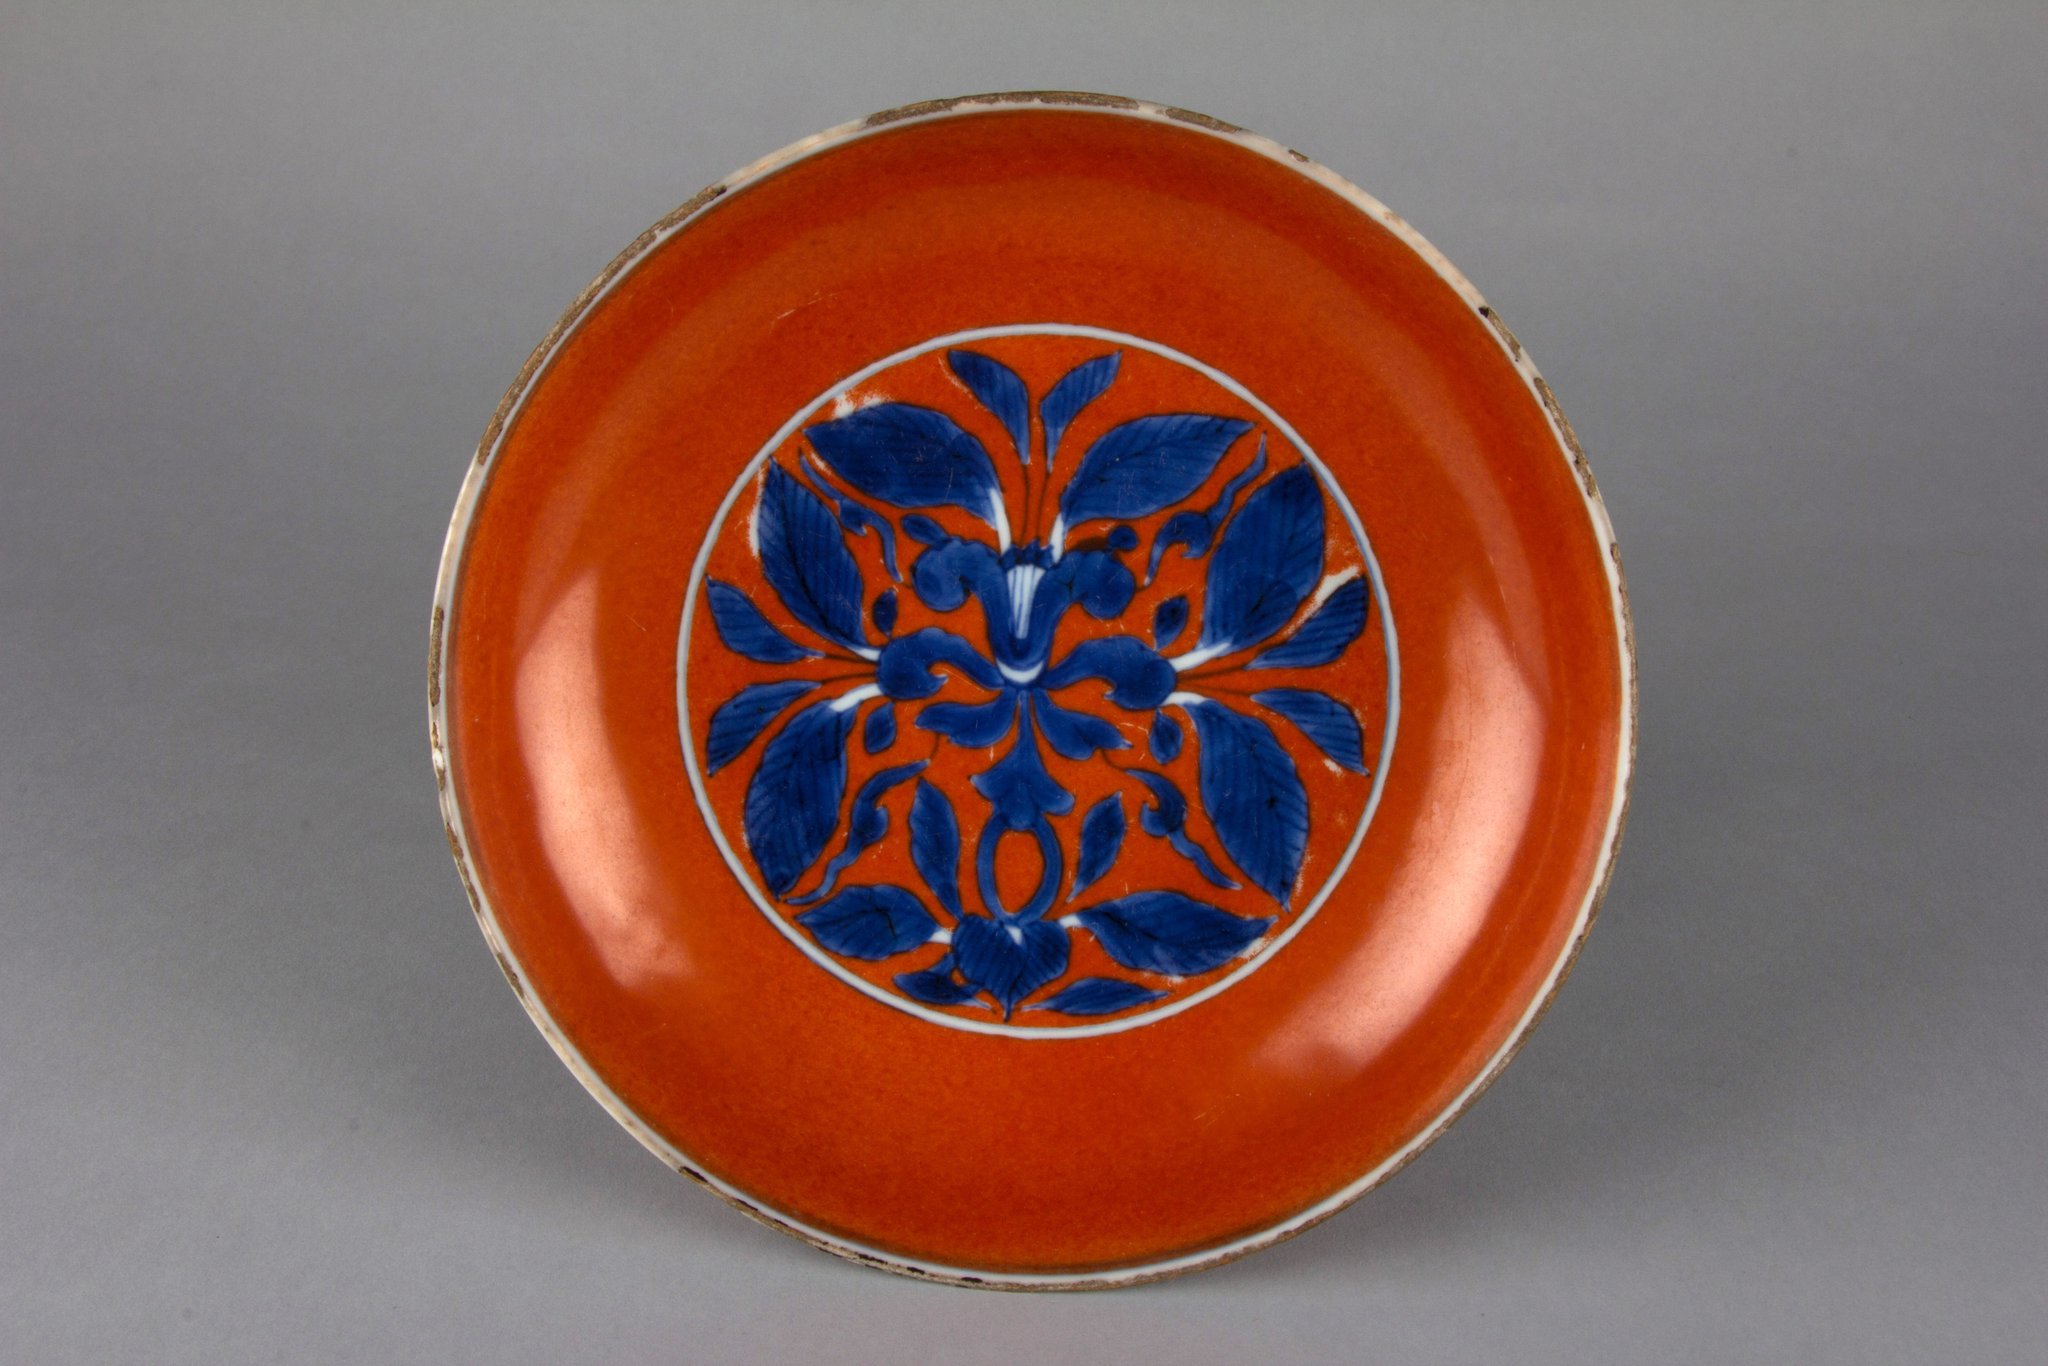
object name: dish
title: Dish with flower scrolls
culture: chinese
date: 1701-1800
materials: cobalt, enamel, porcelain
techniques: overglaze, painting, underglaze